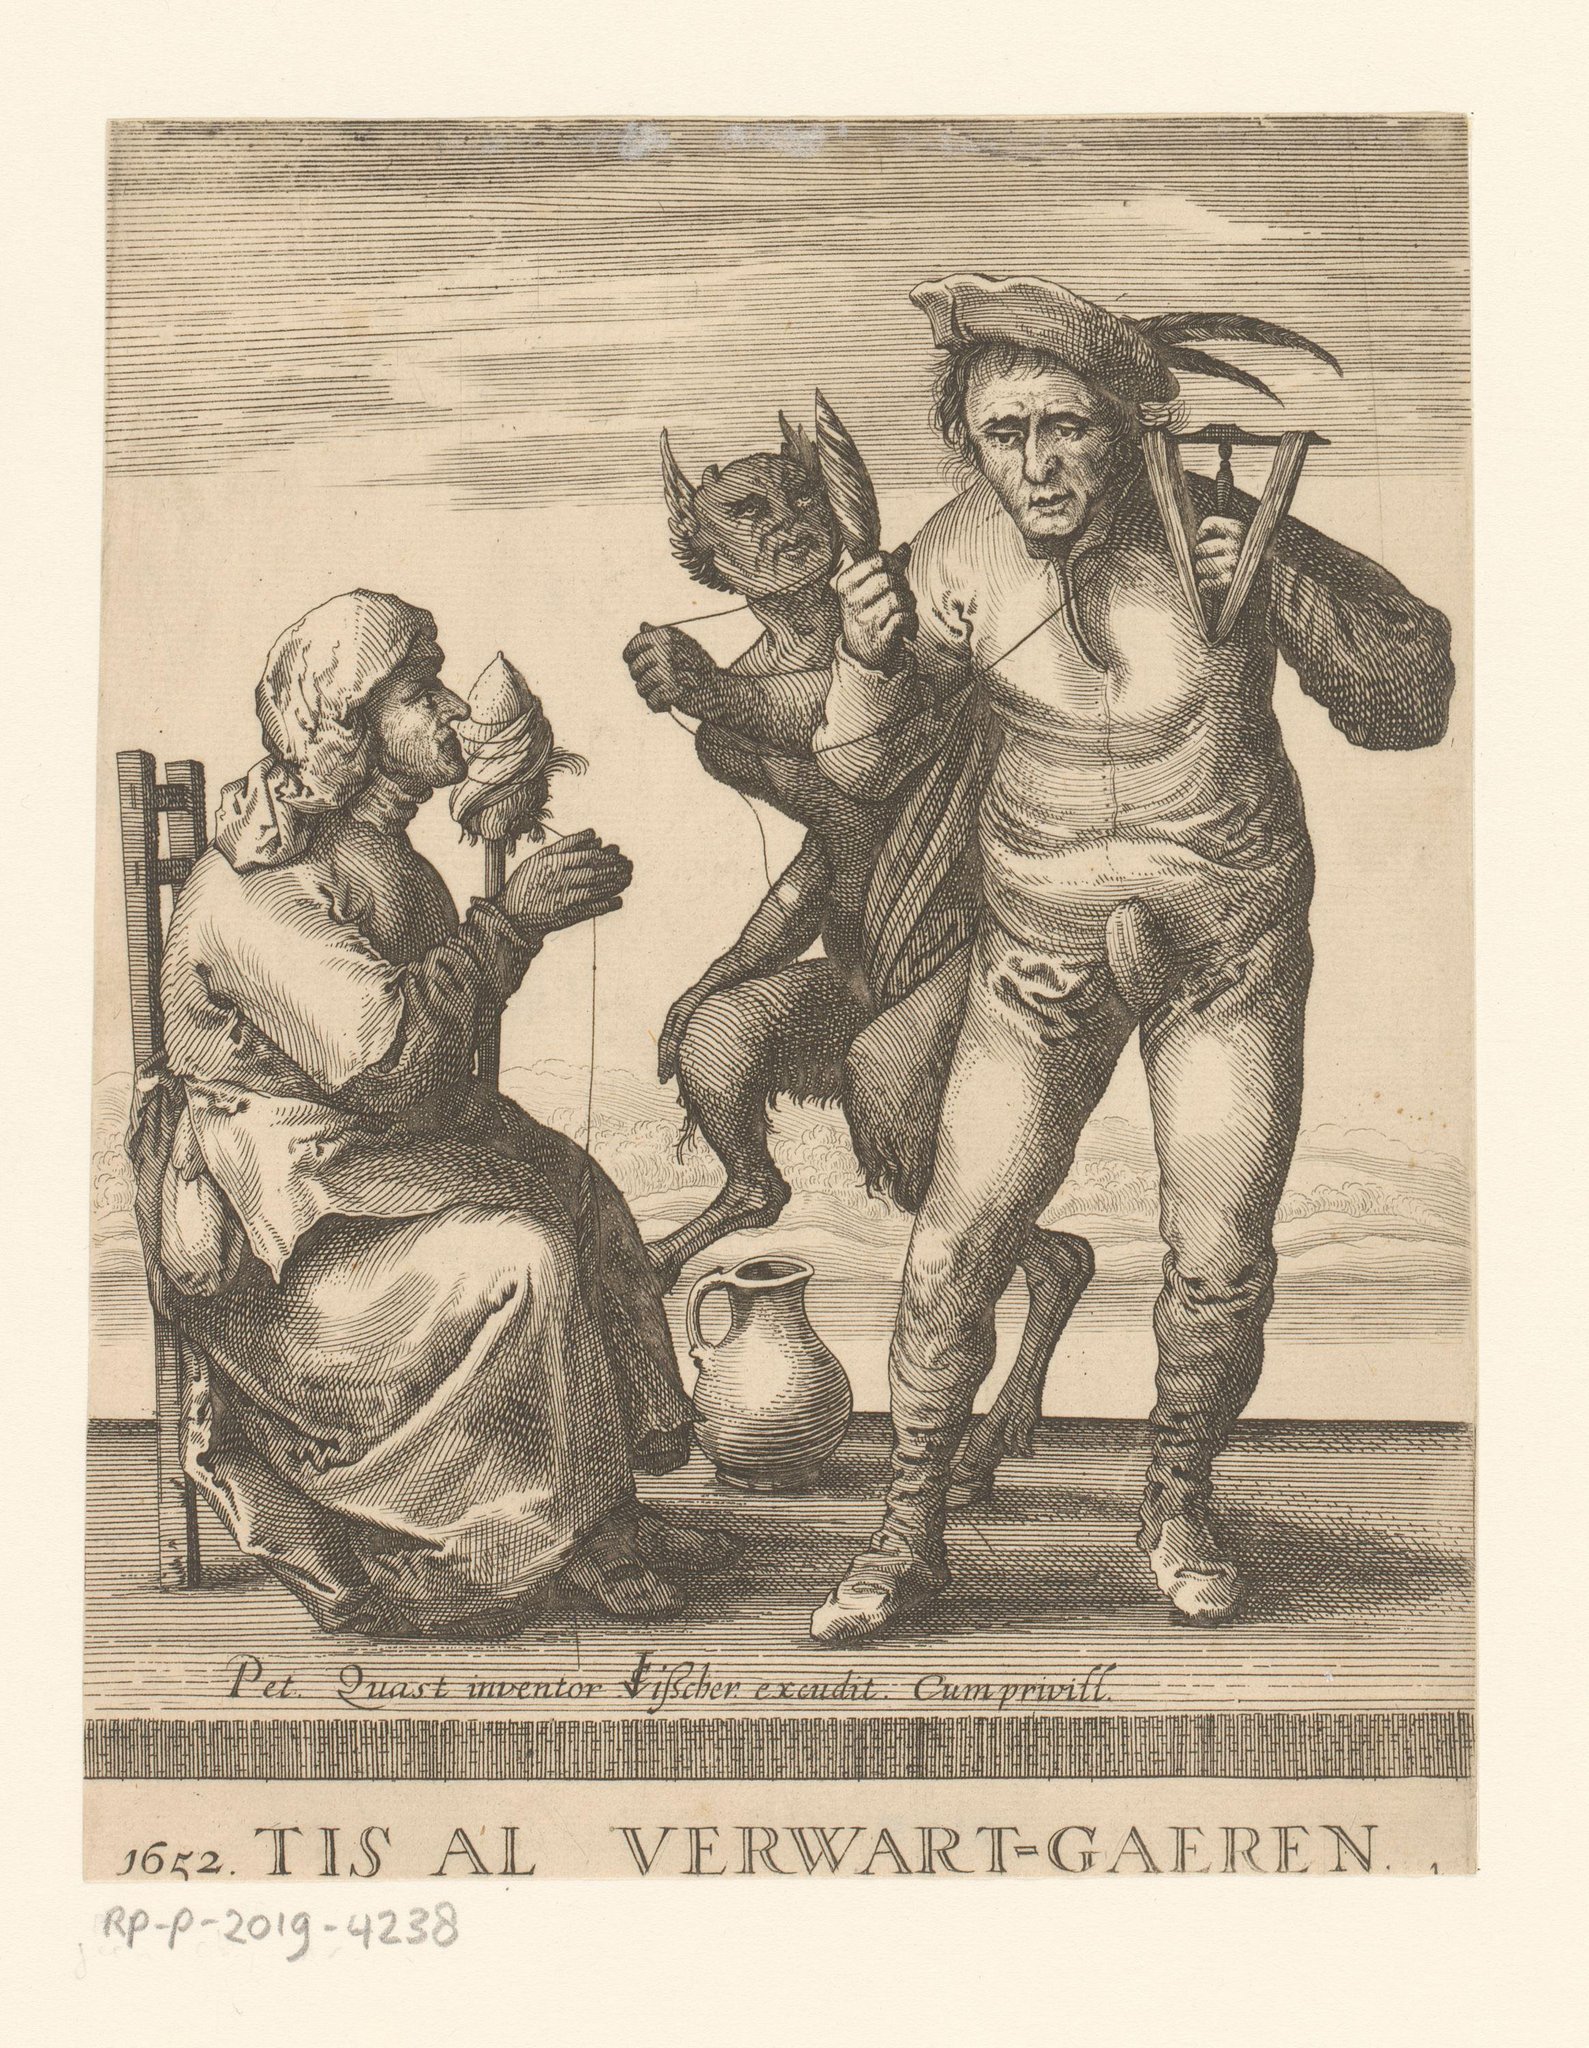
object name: print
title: Duivel verwart het garen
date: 1638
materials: paper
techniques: engraving, etching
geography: amsterdam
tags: devils in the form of (fabulous) animals, spinning (manufacture of yarn)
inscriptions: collector's mark: Lugt 2228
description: Door Muller opgenomen als mogelijk een spotprent of allegorie op de Engelsen tijdens de Eerste Engelse Oorlog vanwege het jaartal 1652 en het gebruik van een kopie naar deze voorstelling door Salomon Savery in een politieke context (zie FMH 2046A, bijvoorbeeld RP-P-OB-5562). De eerste staat van deze prent werd in 1638 door Hondius uitgegeven.